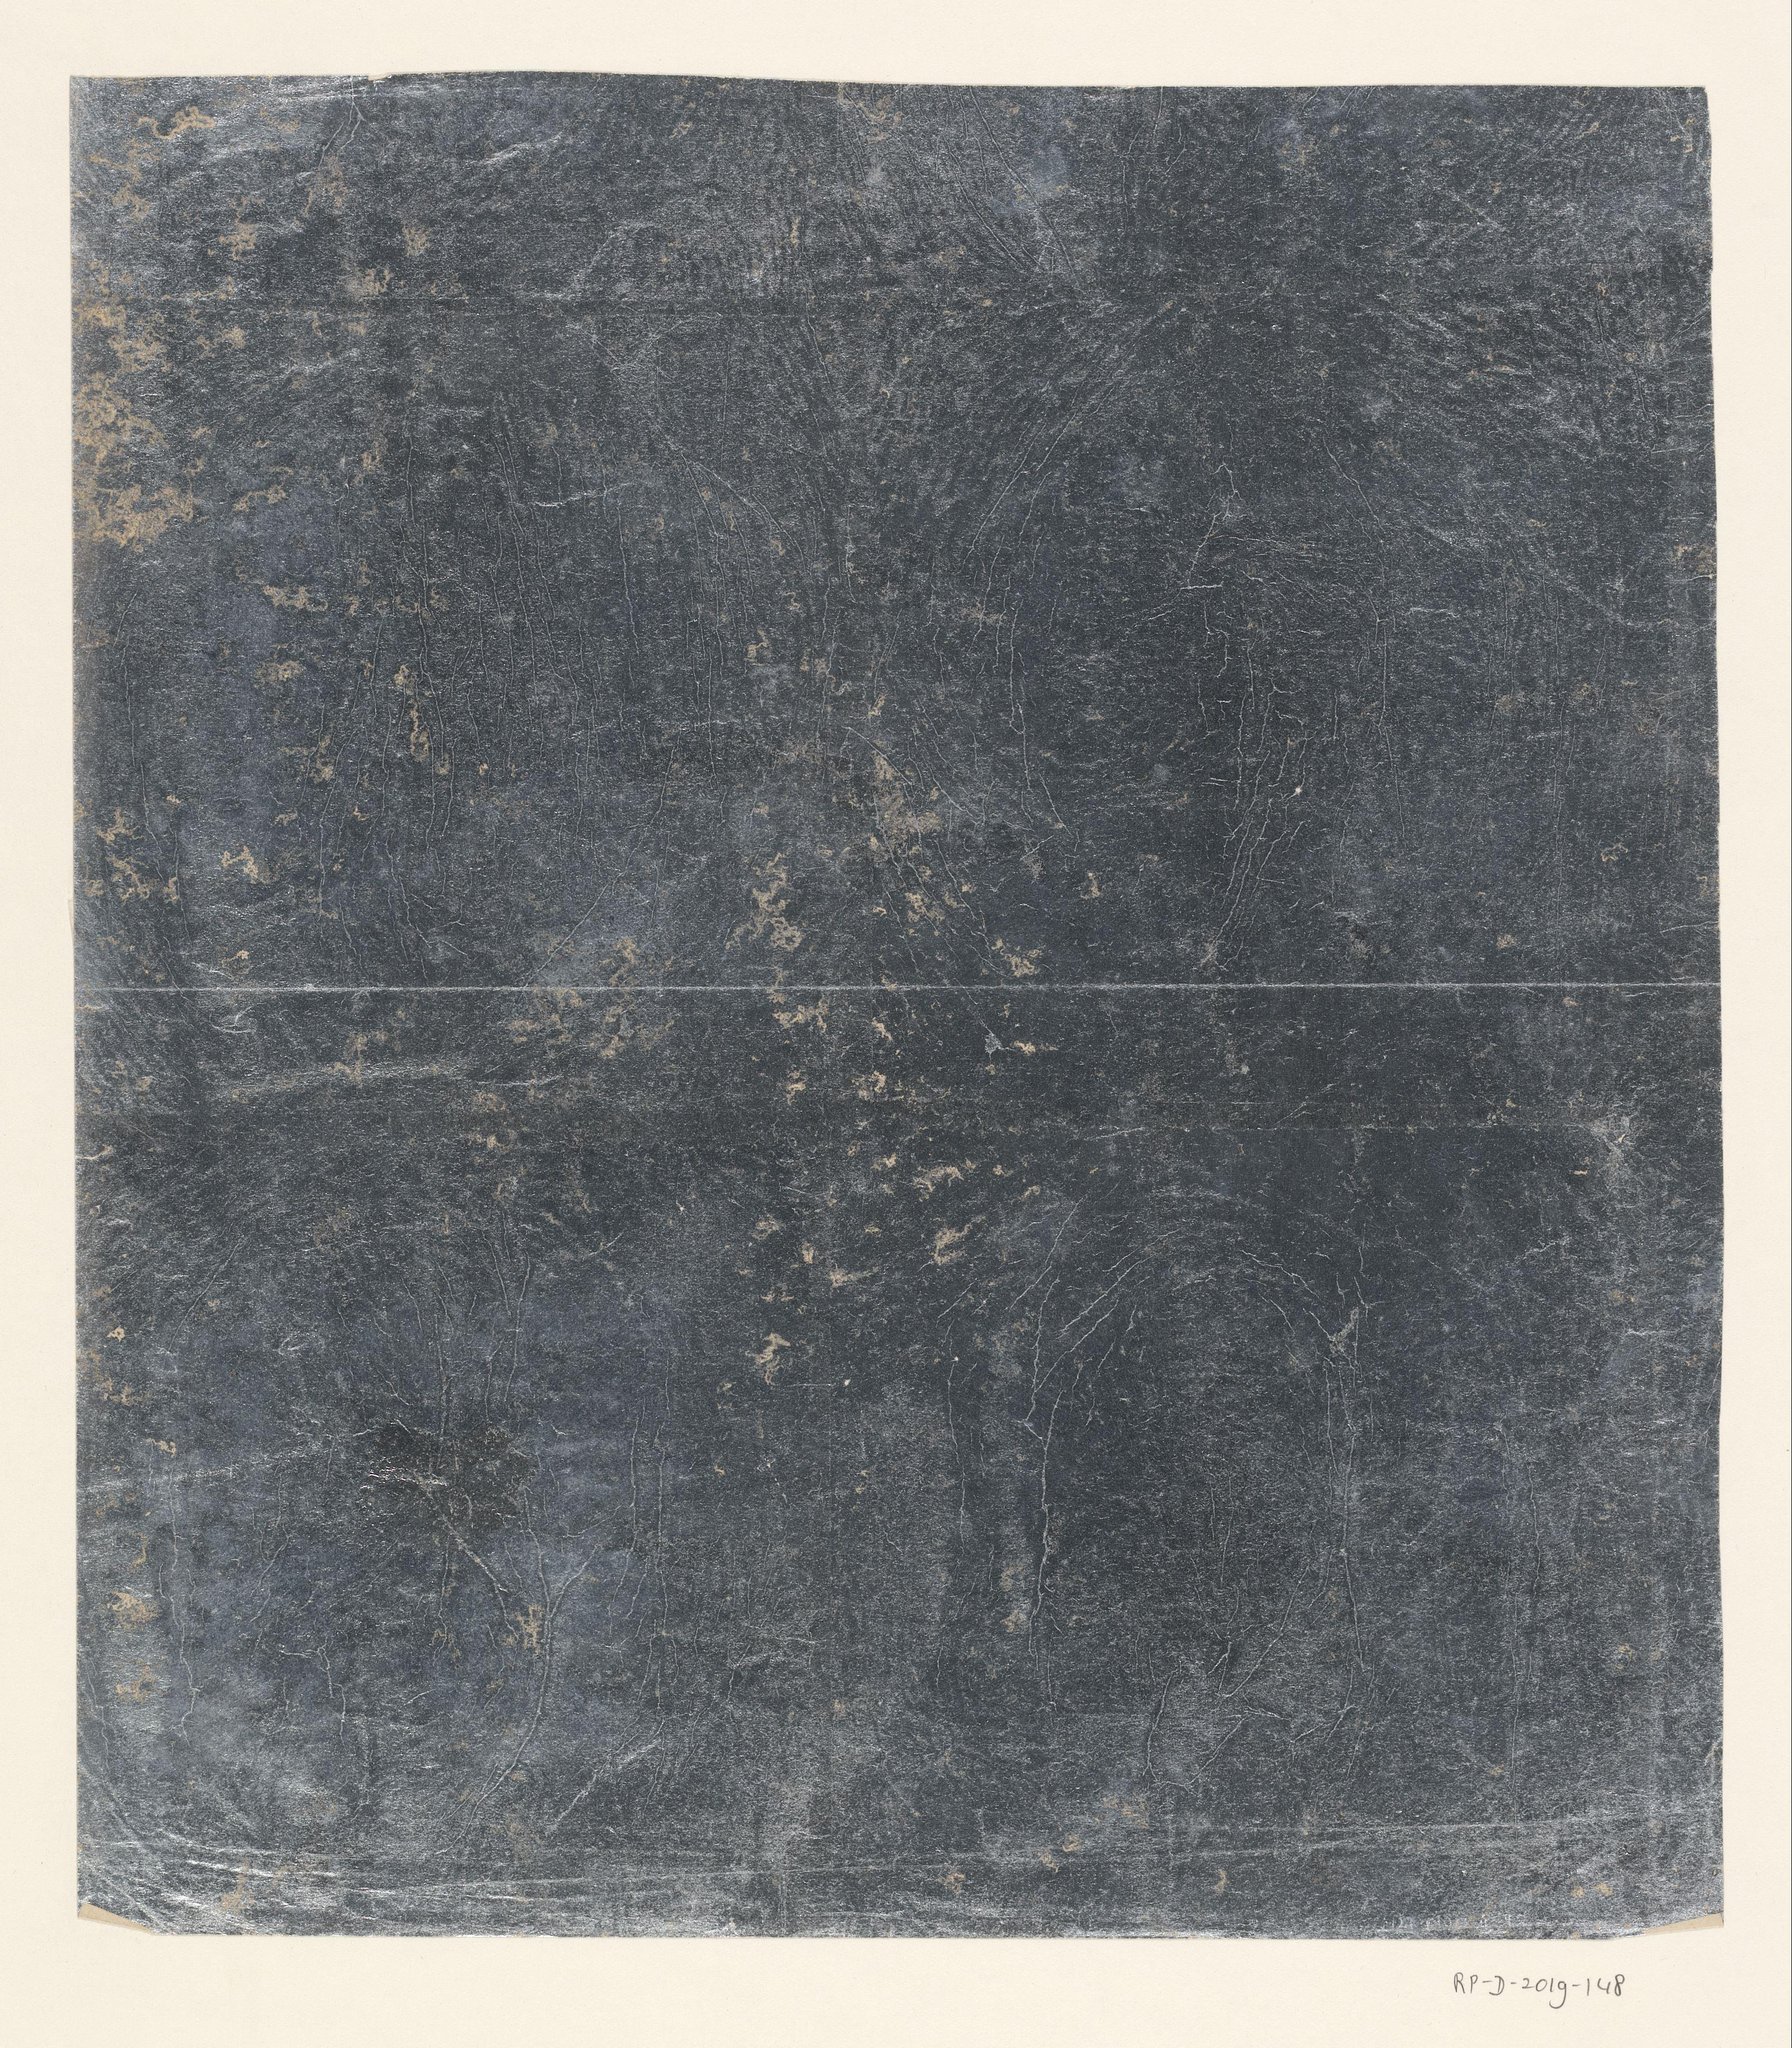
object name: metallic paper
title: Blad effen zilverkleurig metaalpapier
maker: Anonymous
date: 1850-1950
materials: paper, silver leaf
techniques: pasting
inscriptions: collector's mark: Lugt 2228